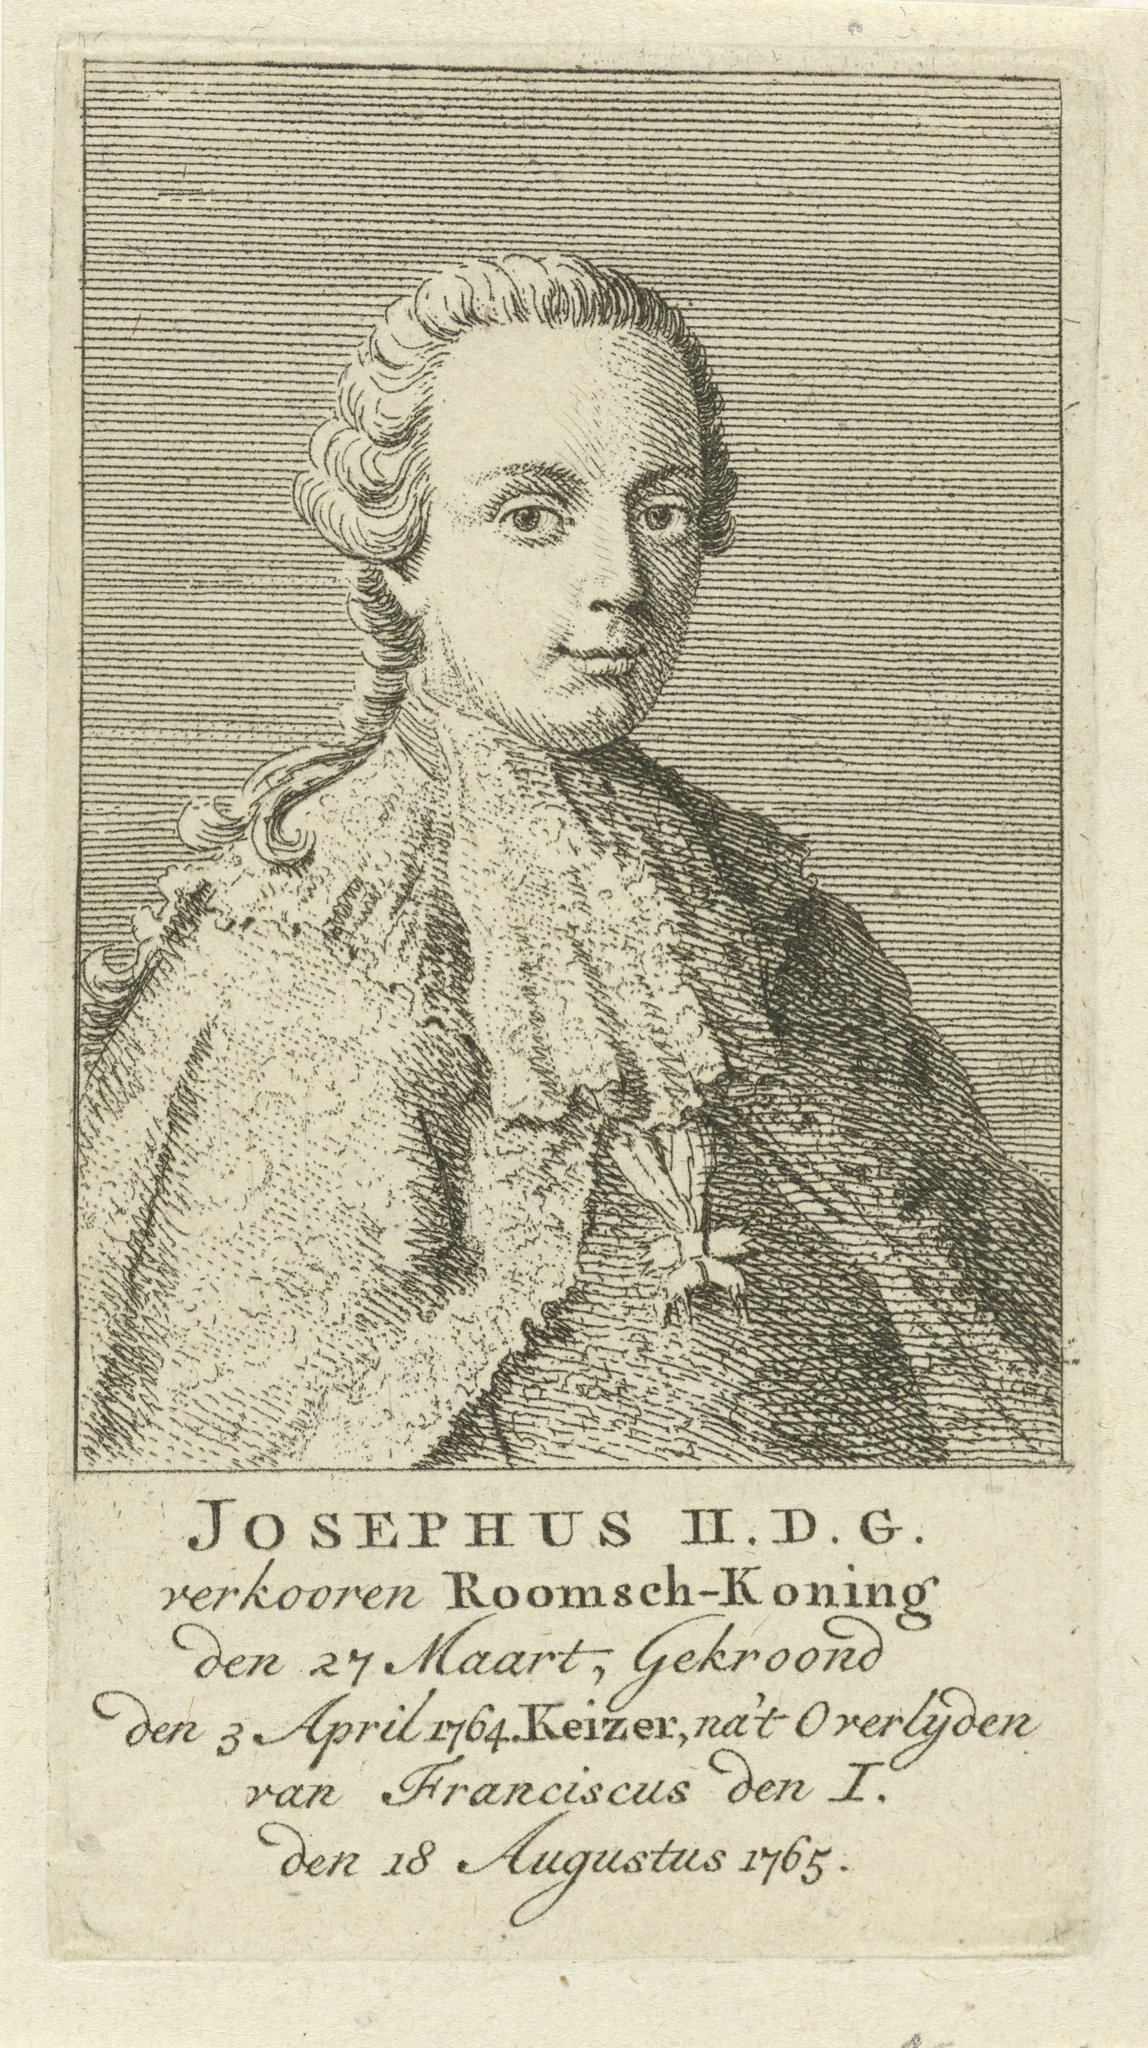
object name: print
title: Portret van Duits keizer Jozef II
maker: cornelis van noorde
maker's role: draughtsman, print maker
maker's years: 1731-1795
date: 1765-1767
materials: paper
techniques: etching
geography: haarlem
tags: jozef ii (duits keizer), knighthood order of the golden fleece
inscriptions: collector's mark: Lugt 2228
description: Portret van Jozef II, Duits keizer, met een ketting om zijn hals van de Orde van het Gulden Vlies.